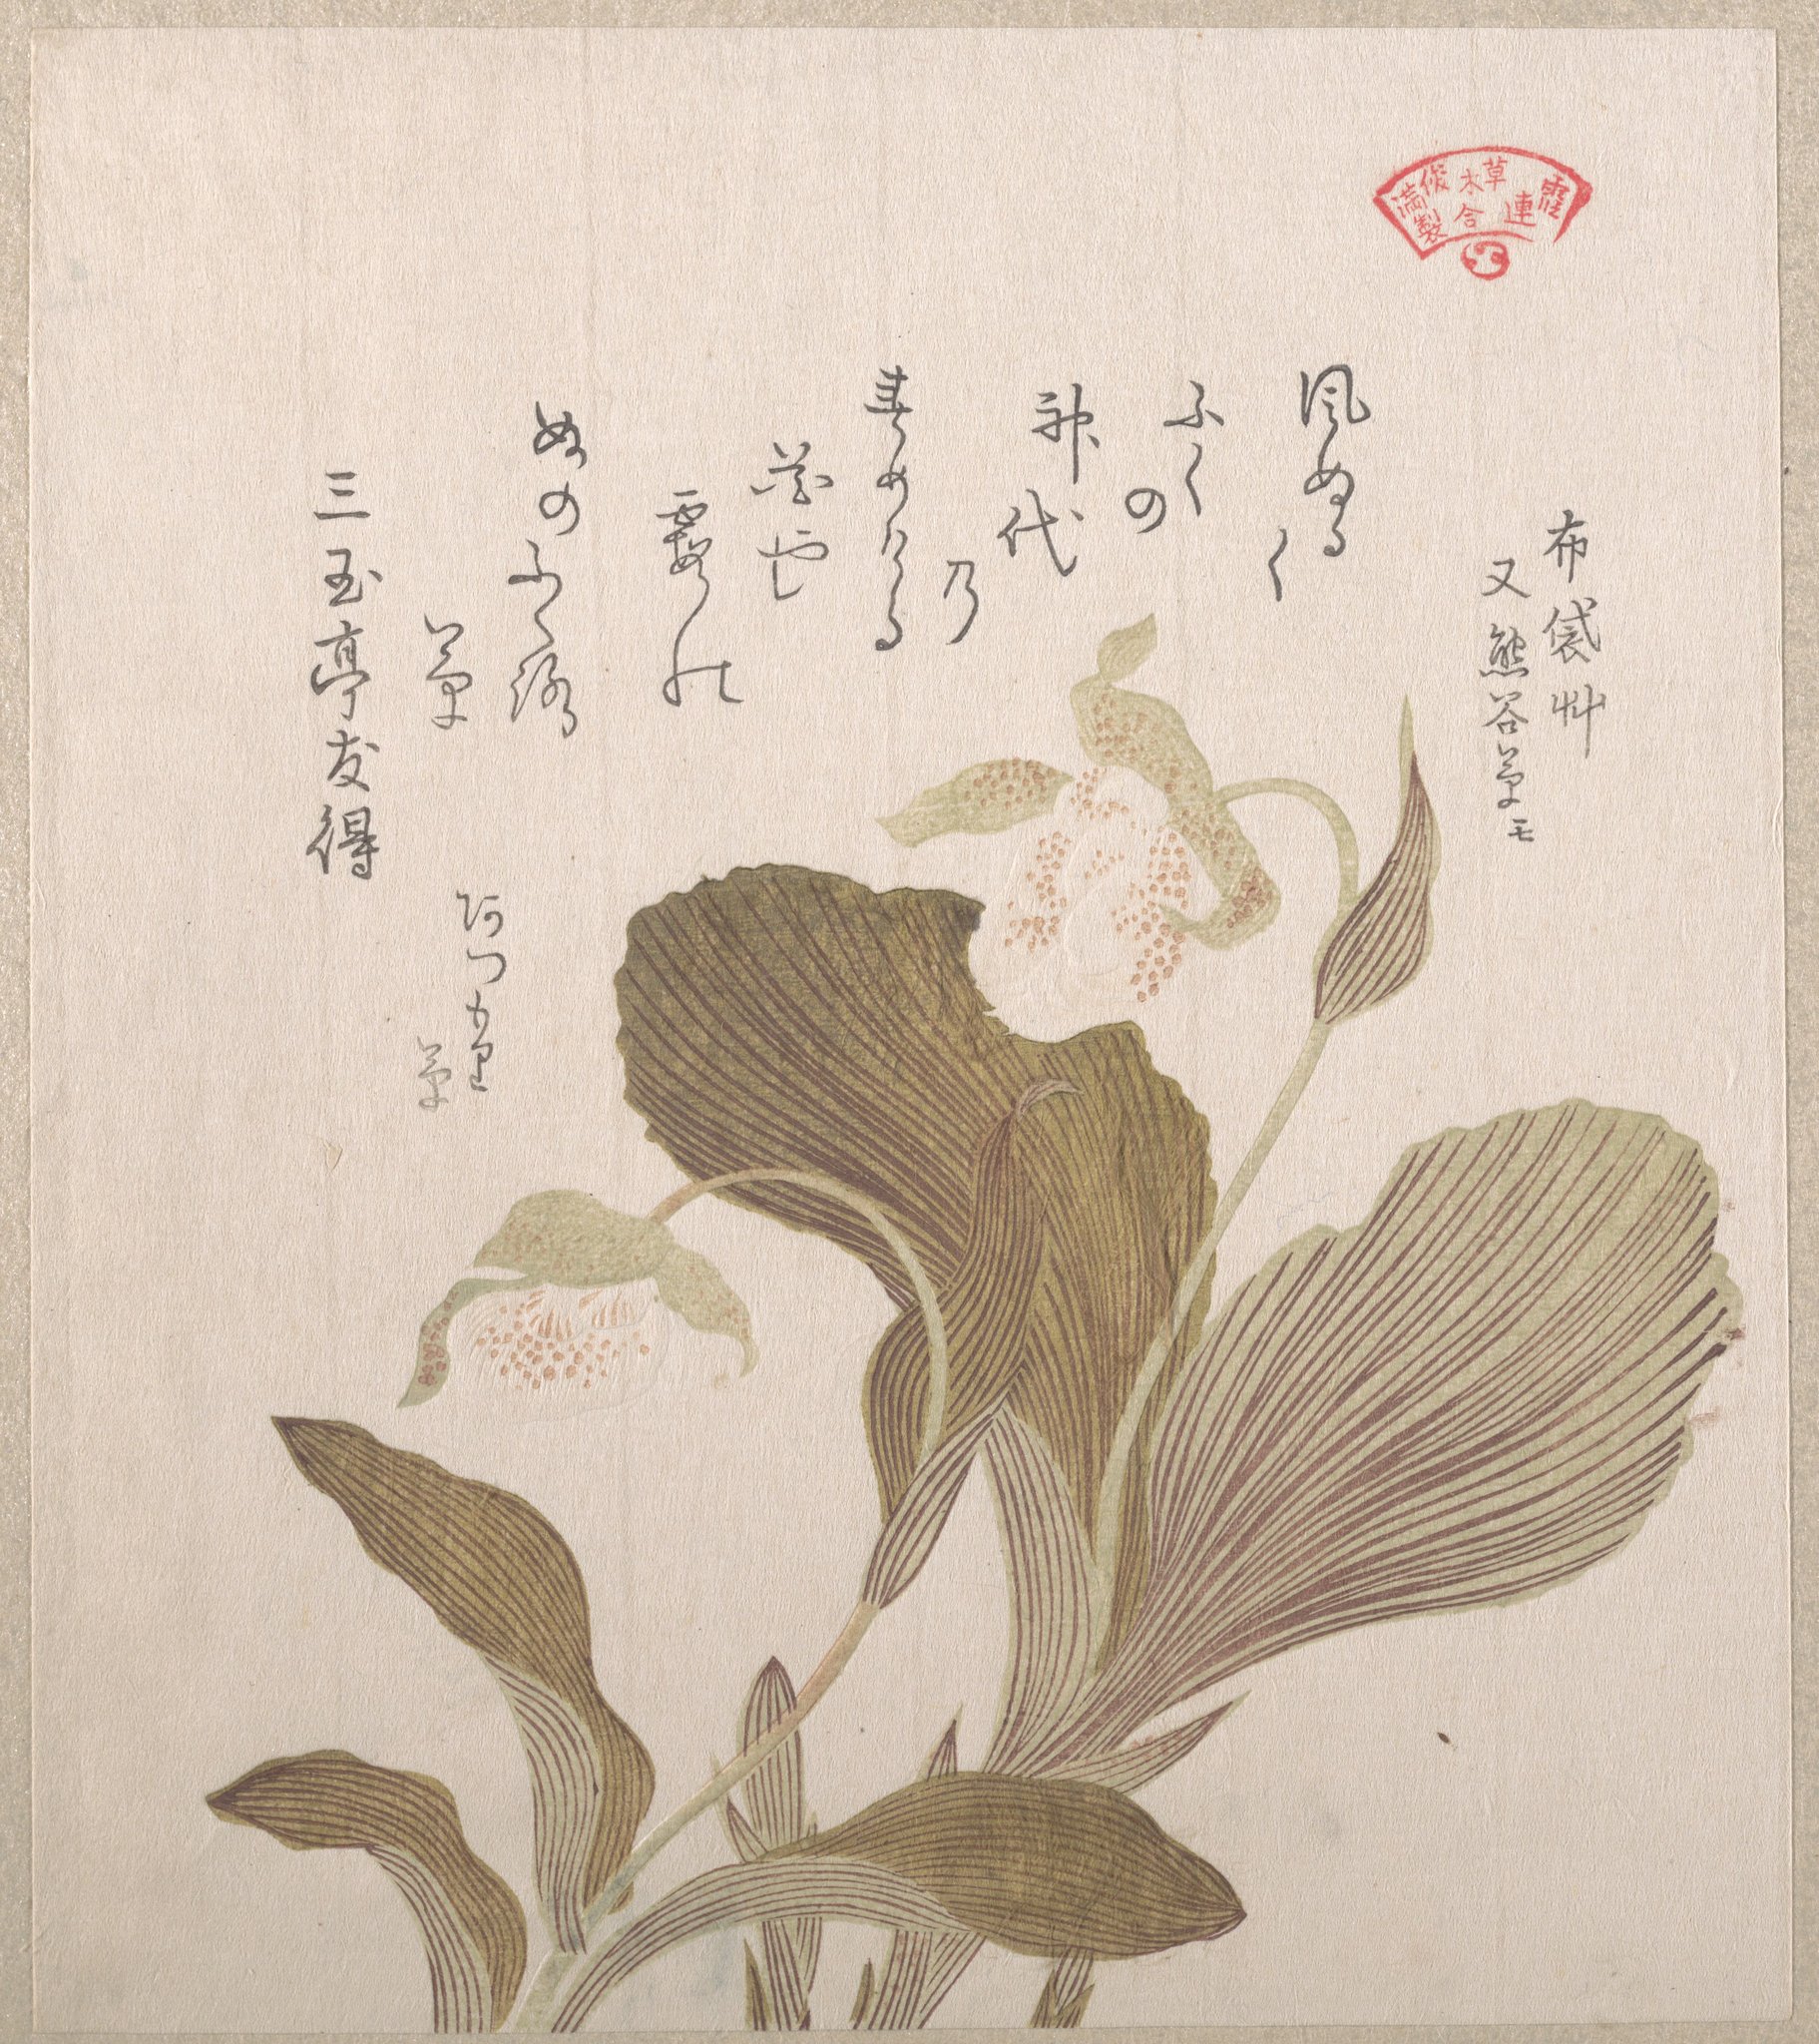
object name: print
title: Hotei Flowers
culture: japanese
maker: kubo shunman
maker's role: artist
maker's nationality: japanese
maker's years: 1757-1820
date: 1801-1900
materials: ink, paper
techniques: surimono, woodblock print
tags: flowers,leaves